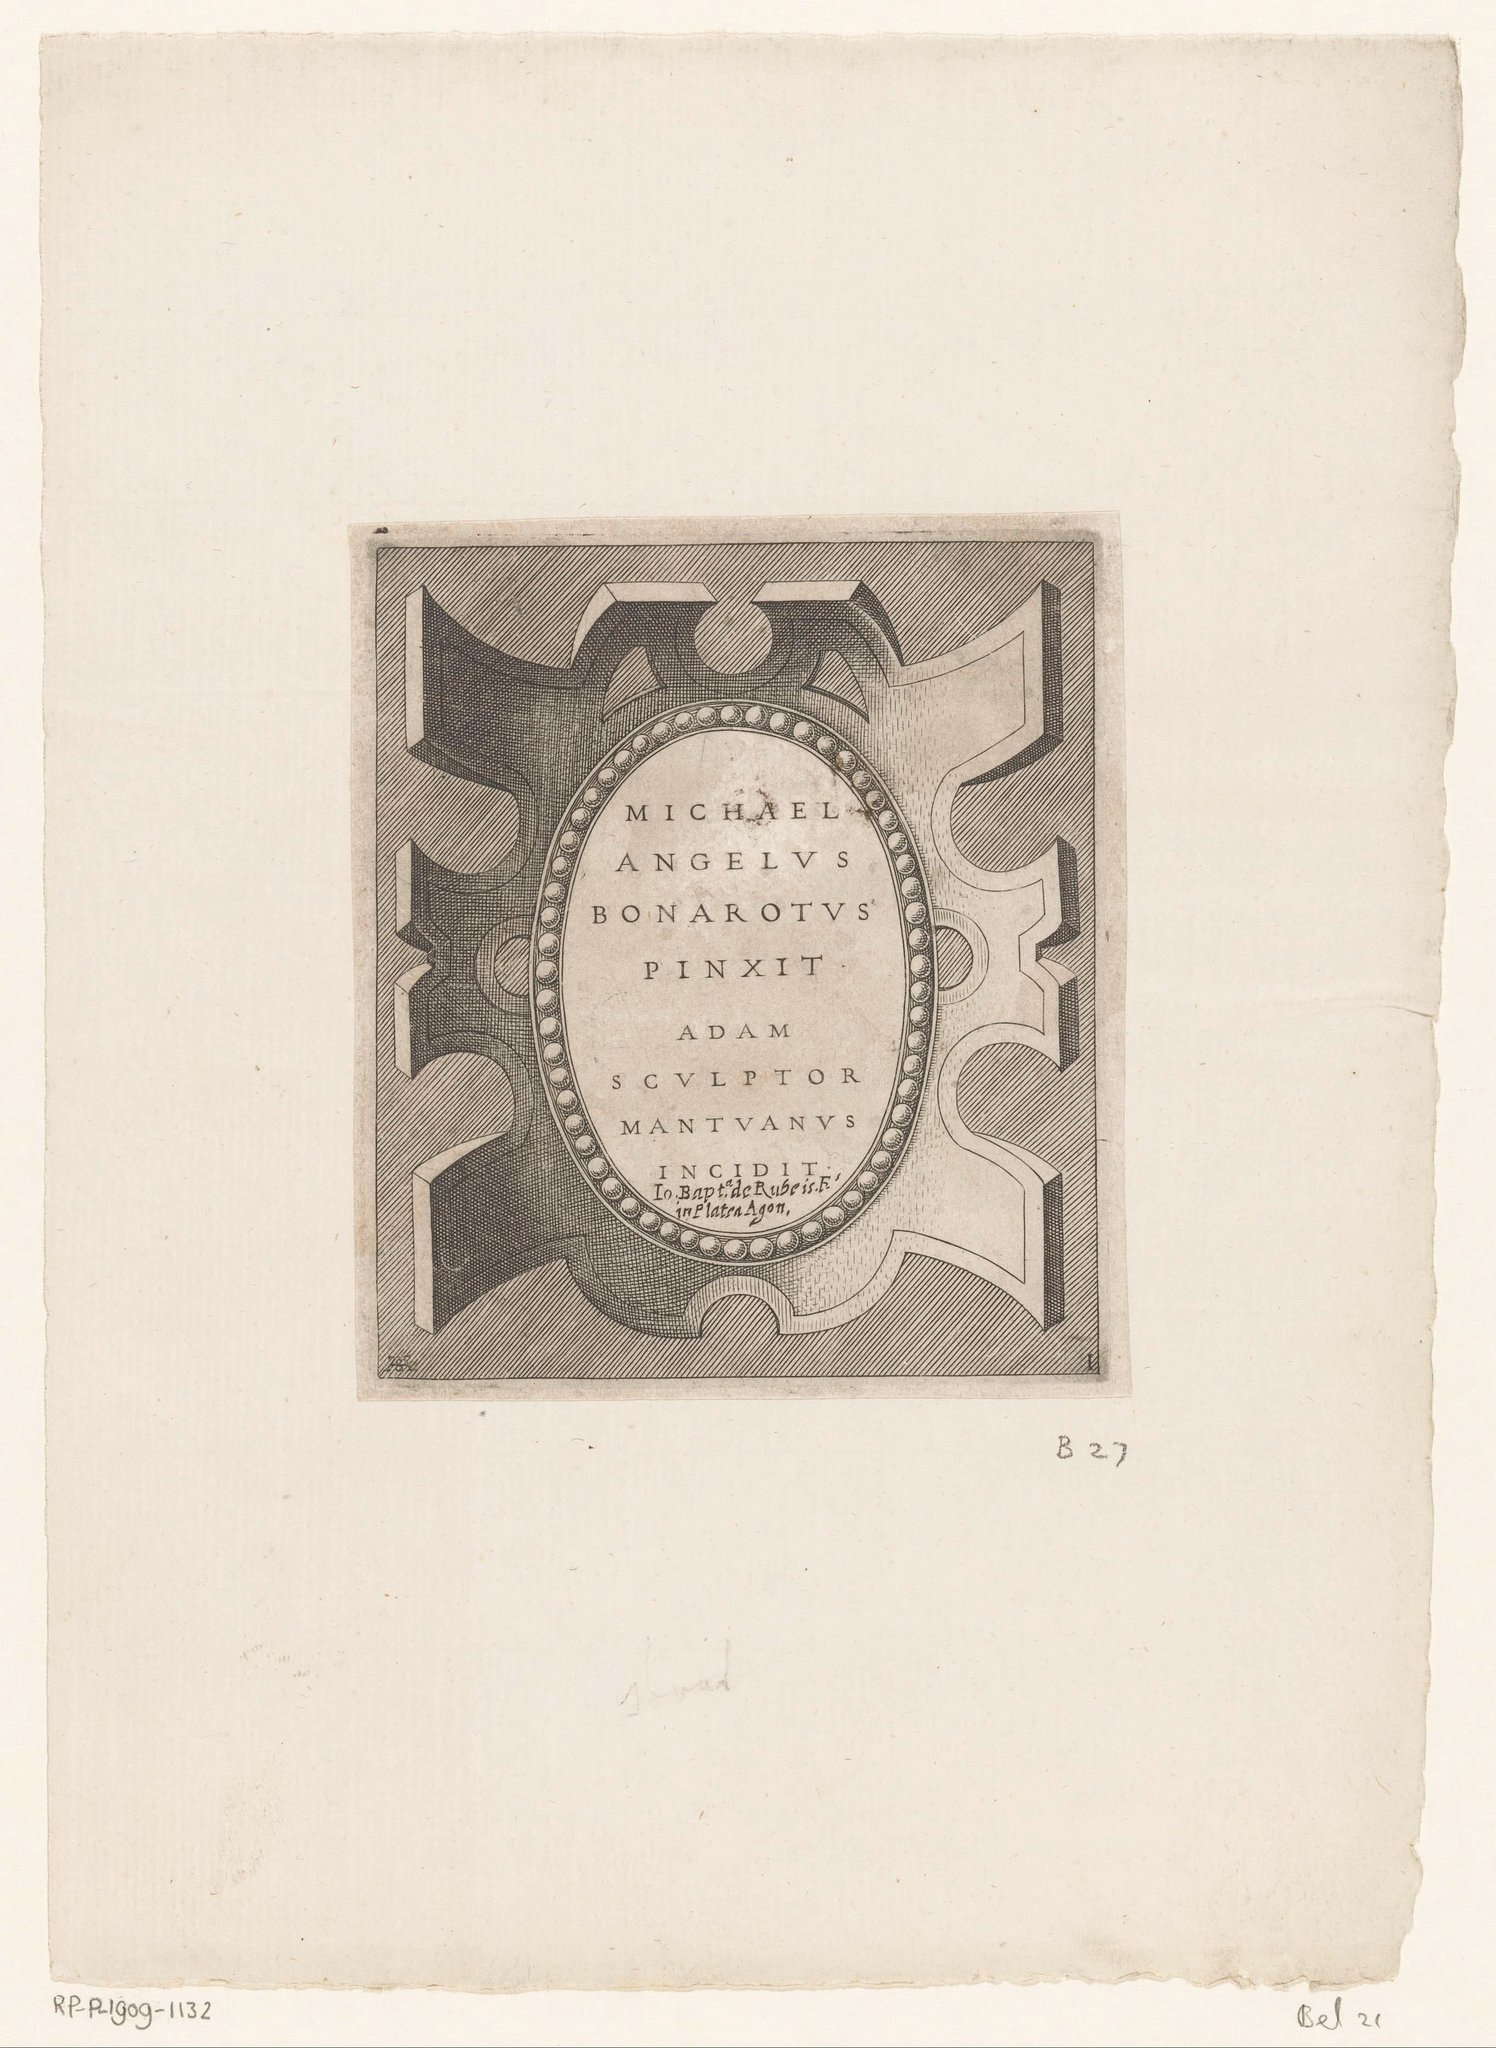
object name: print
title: Titelprent met cartouche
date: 1585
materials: paper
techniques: engraving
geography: italy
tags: ornament ~ cartouche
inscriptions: collector's mark: Lugt 2228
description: Titelprent van een serie die behalve de titelprent bestaat uit 72 prenten naar schilderingen door Michelangelo in de Sixtijnse Kapel in het Vaticaan.